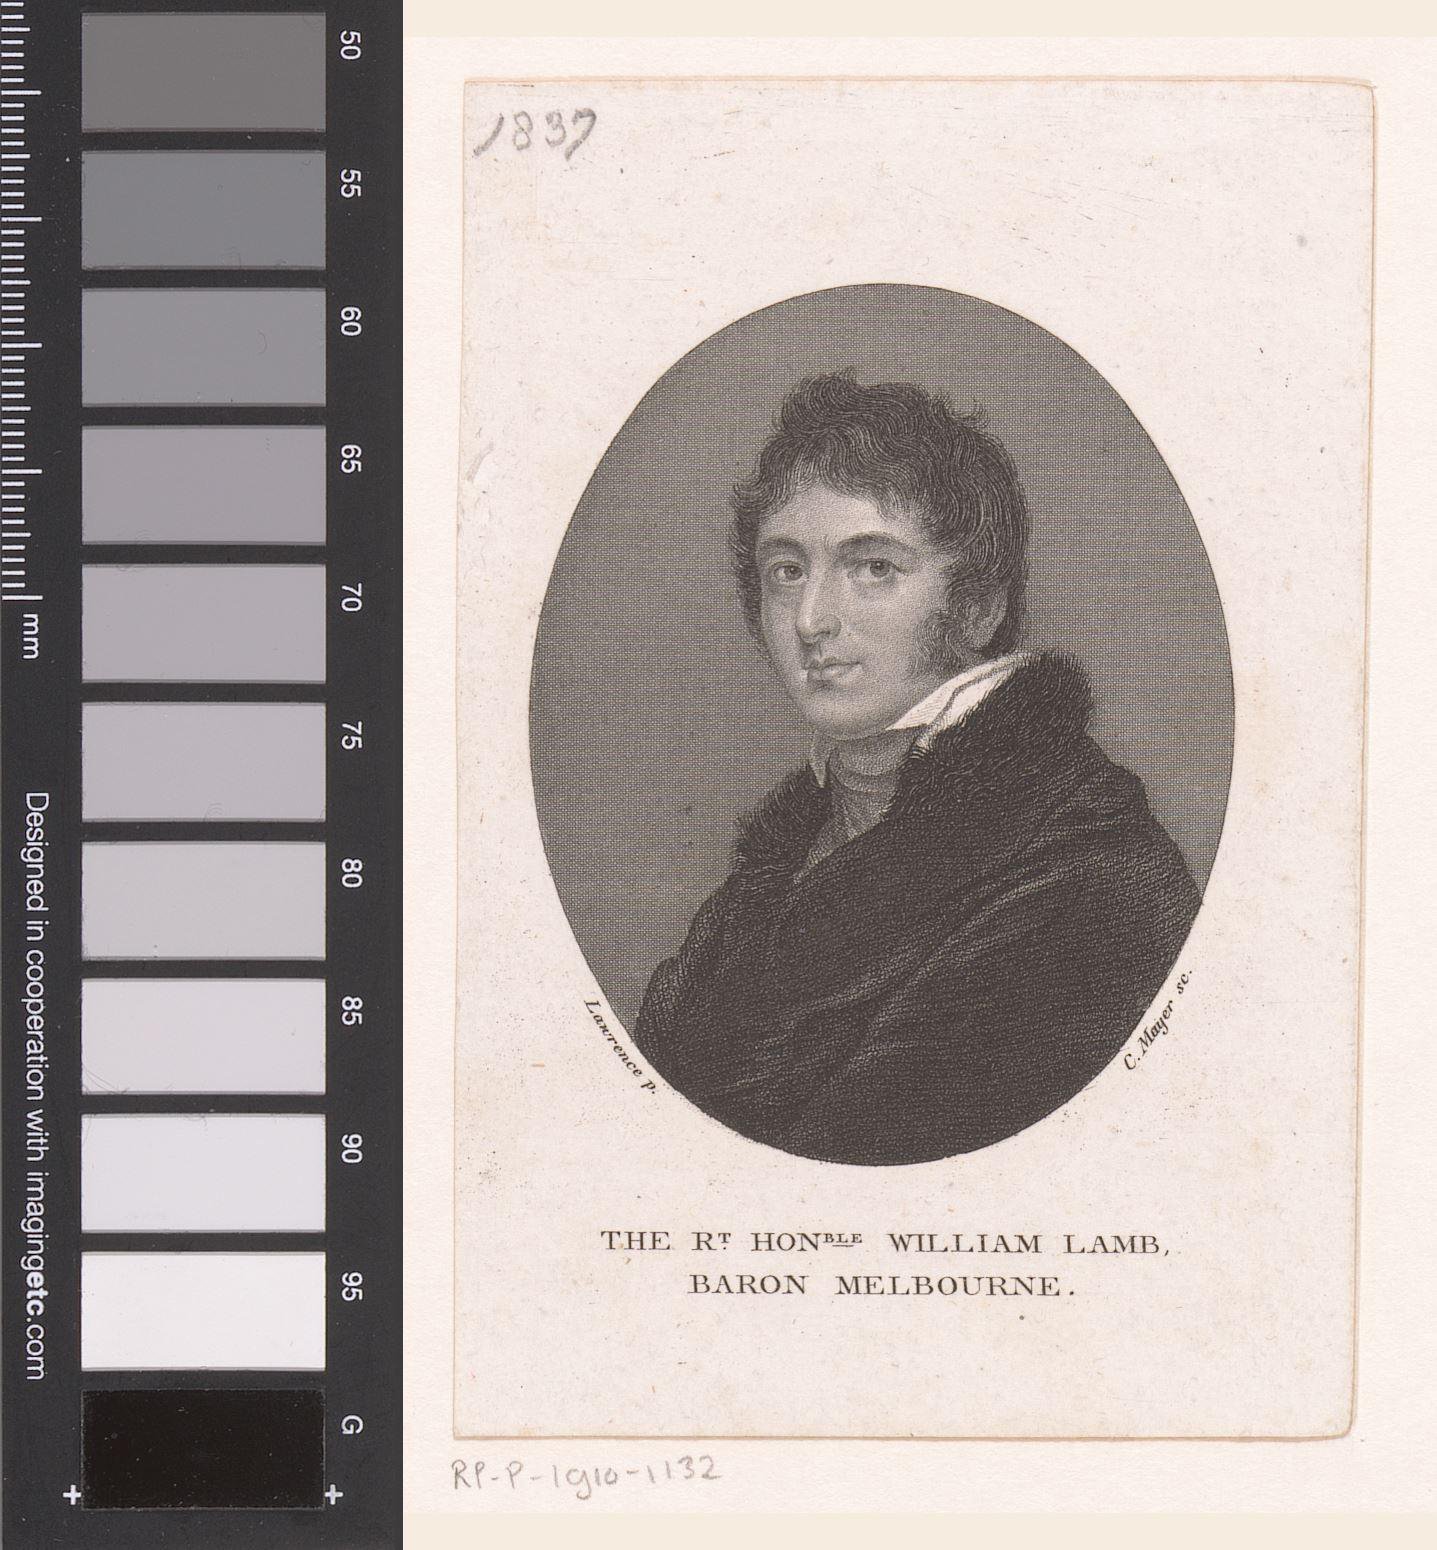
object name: print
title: Portret van William Lamb, 2nd Viscount Melbourne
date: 1830-1868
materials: paper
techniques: engraving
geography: nuremberg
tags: historical persons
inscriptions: collector's mark: Lugt 2228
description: Prent mogelijk afkomstig uit de Almanach de Gotha.